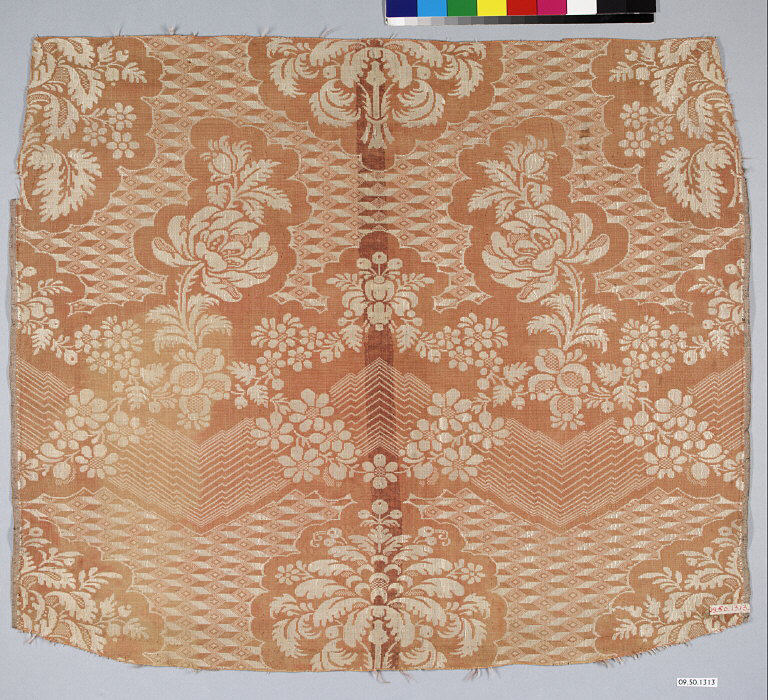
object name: piece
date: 1701-1800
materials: silk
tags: flowers,leaves